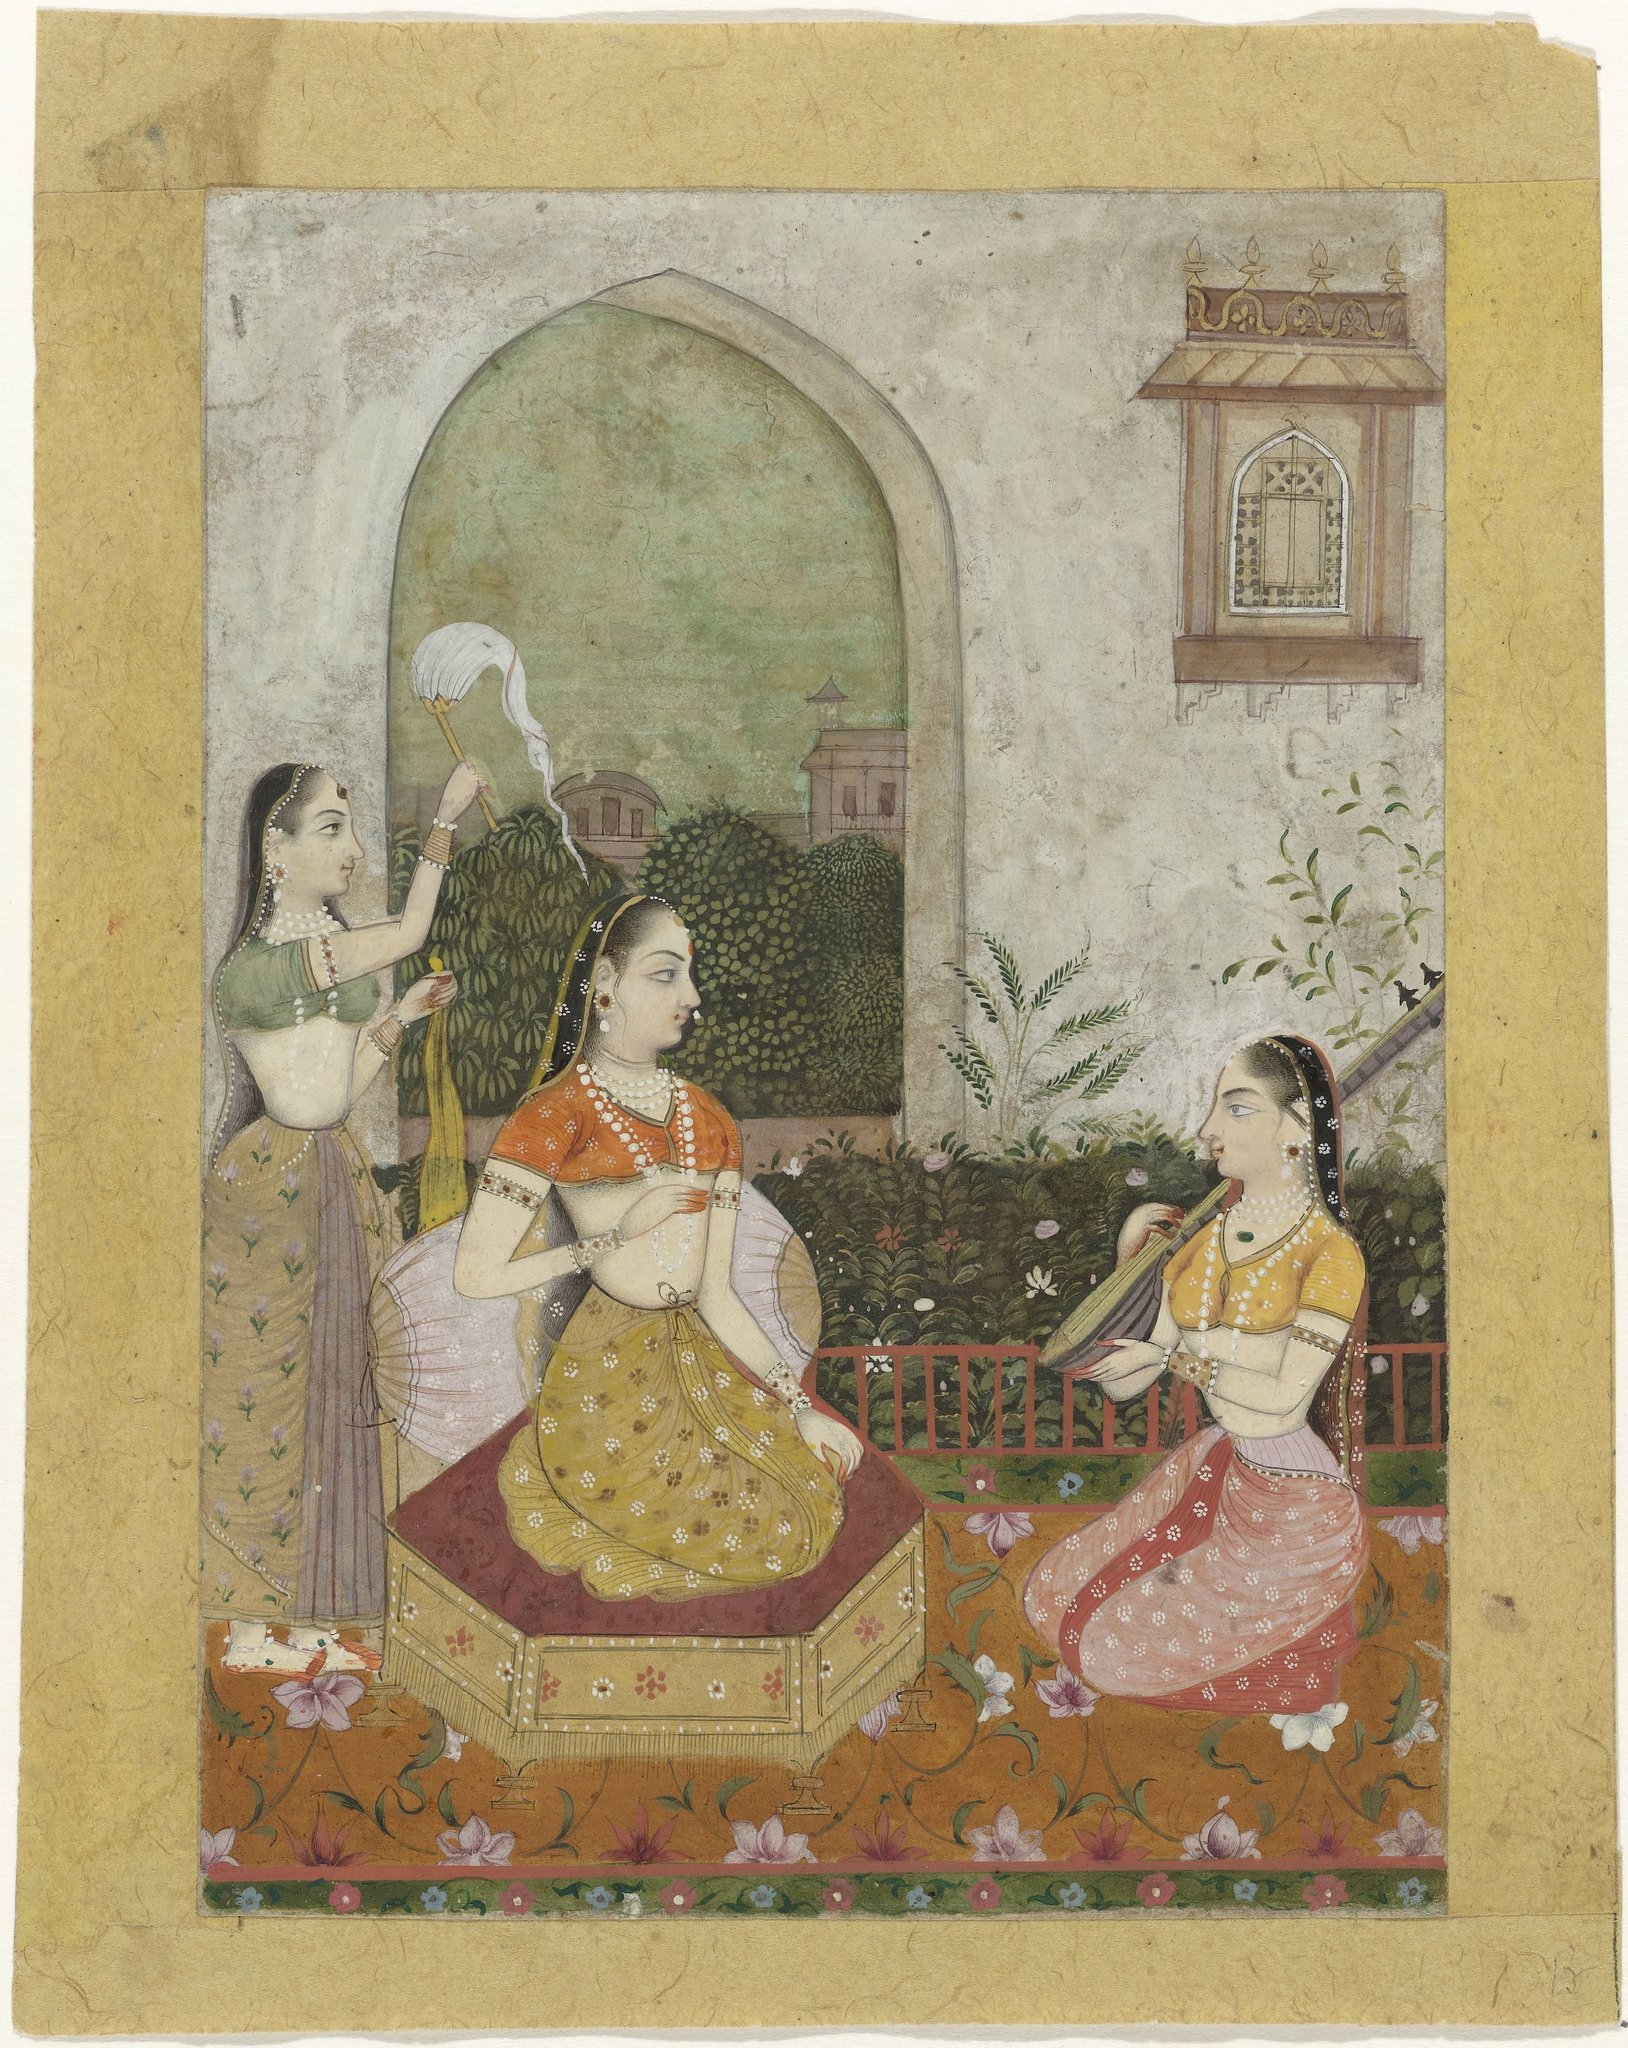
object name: drawing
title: Prinses en twee dienaressen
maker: Anonymous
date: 1660-1680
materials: gouache, paper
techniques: brush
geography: bikaner